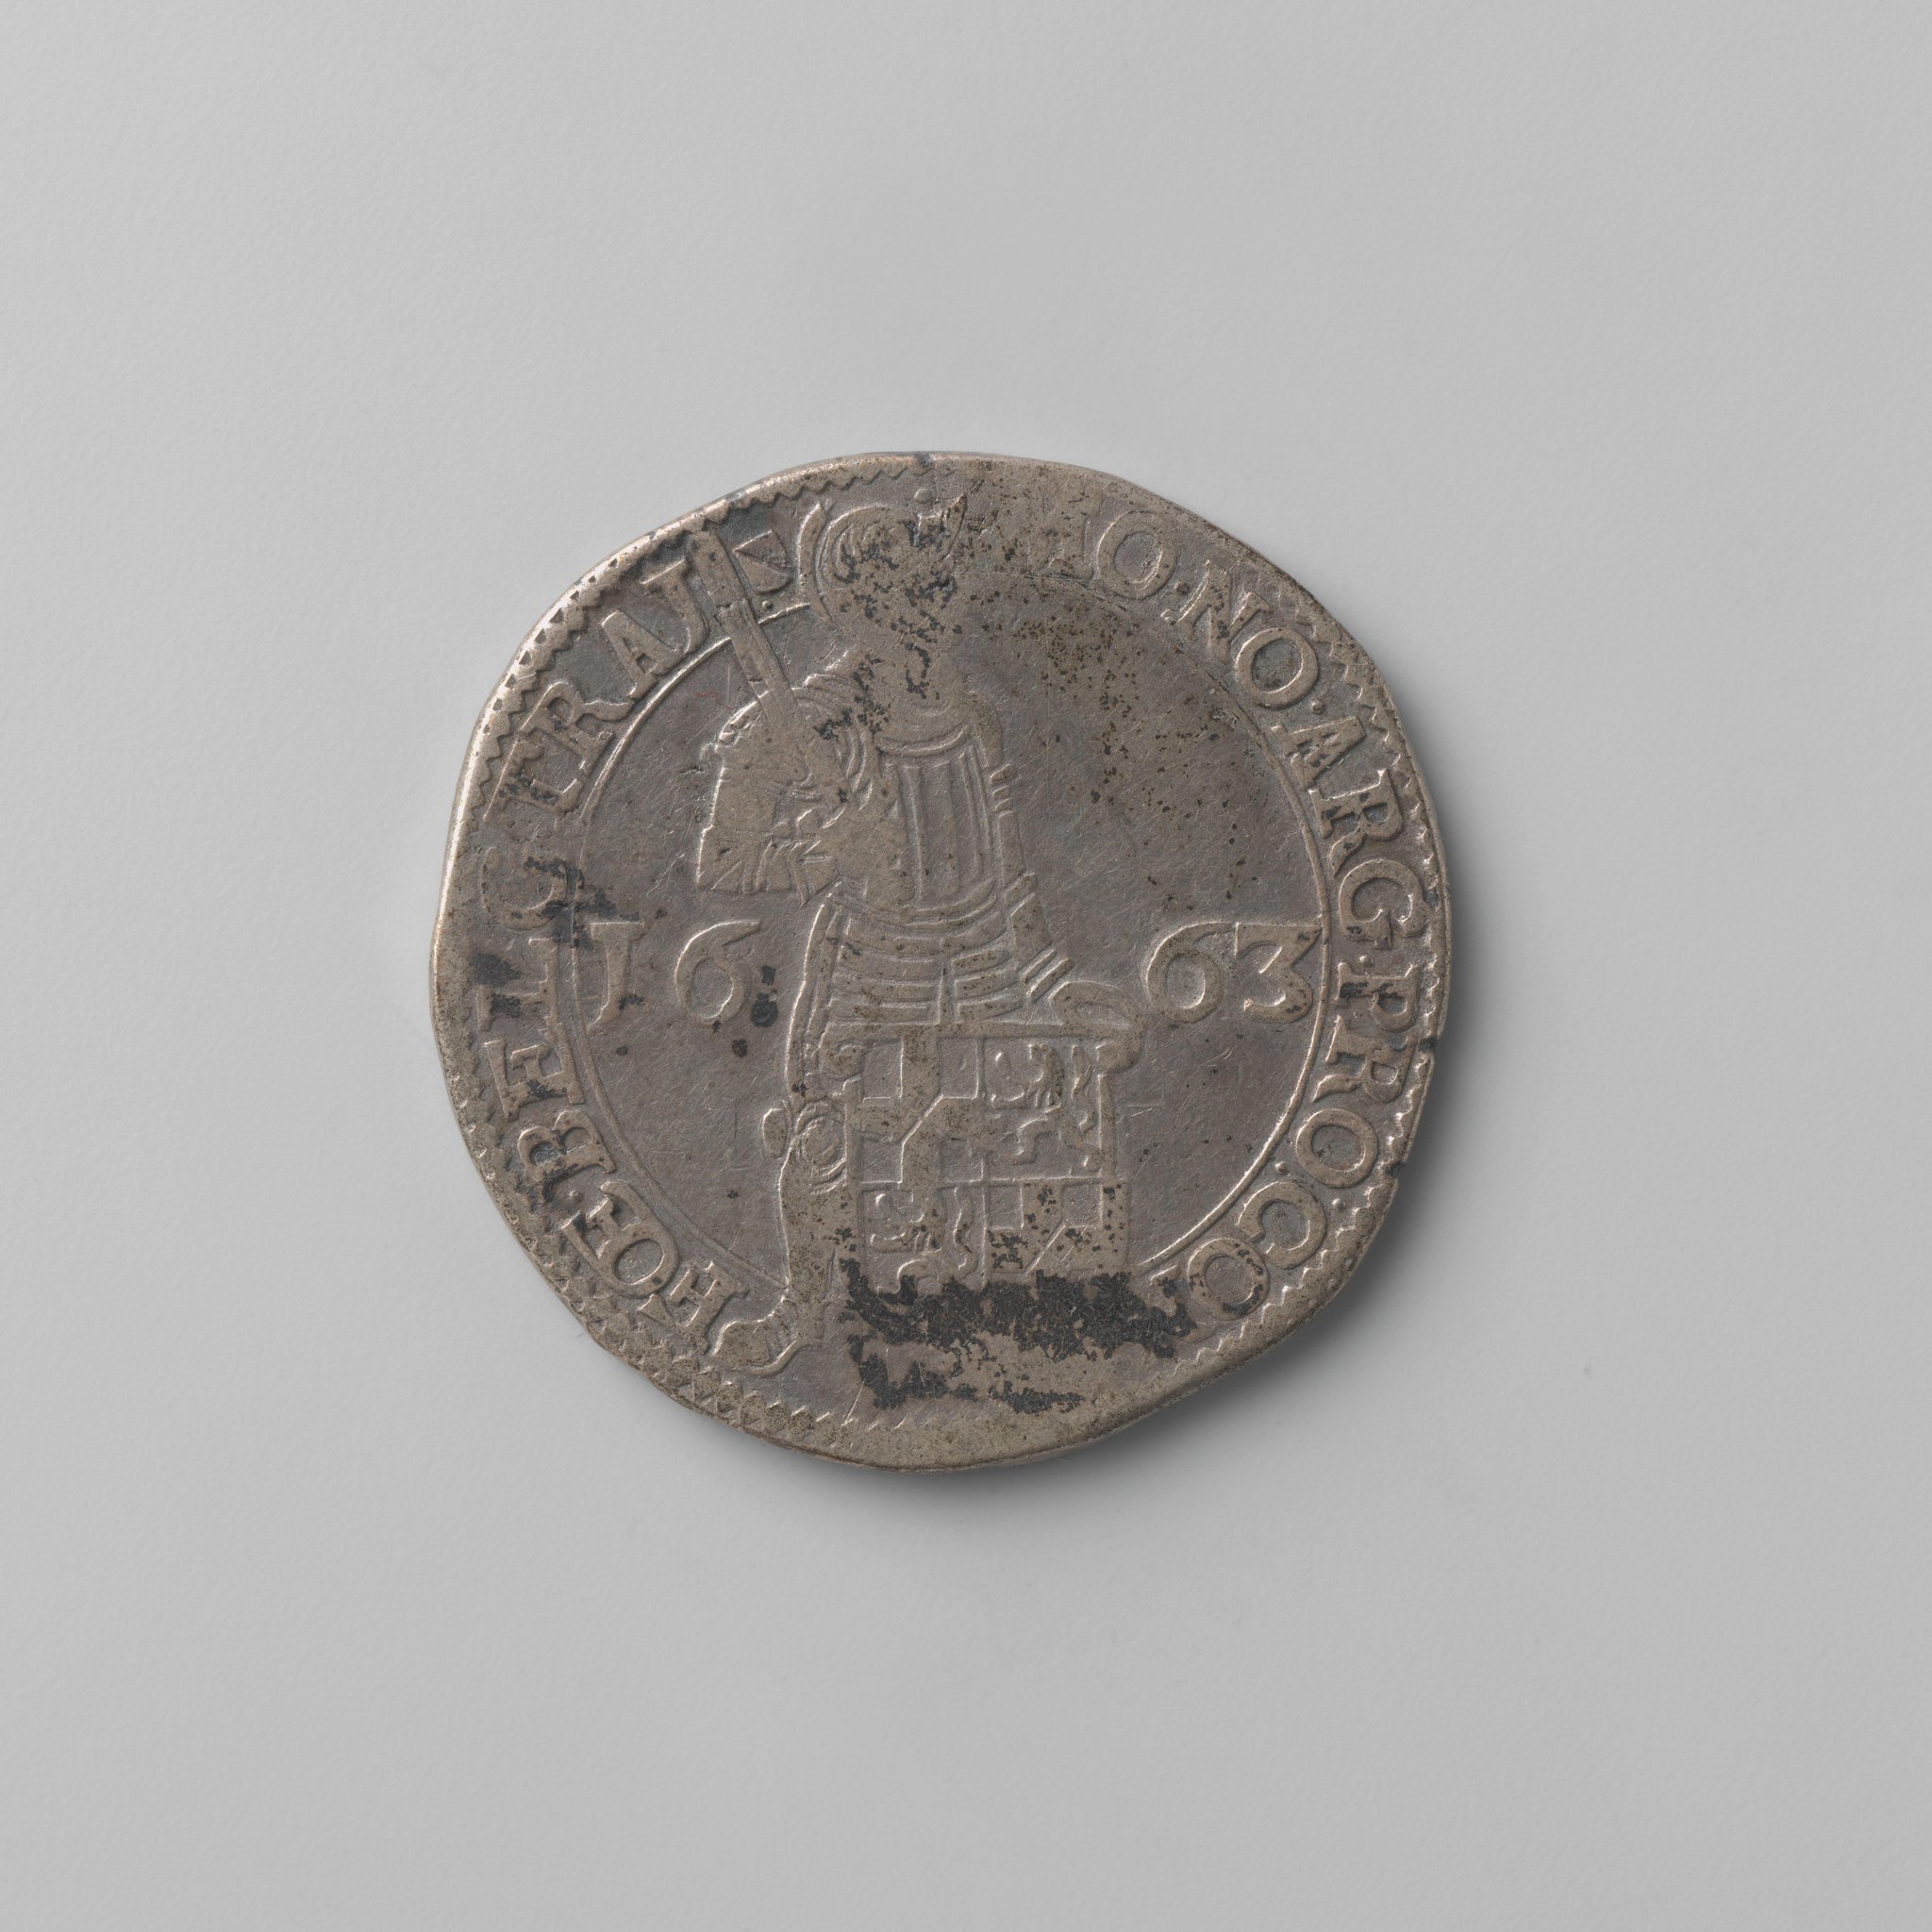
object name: zilveren dukaat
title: Utrechtse halve zilveren dukaat, 1663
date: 1663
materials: silver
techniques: striking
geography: utrecht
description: Zilveren munt. Voorzijde:tussen jaartal staande geharnaste ridder naar rechts met zwaard in rechterhand en wapenschild van Utrecht aan linkerhand. Keerzijde: gekroond generaliteitswapenschild.